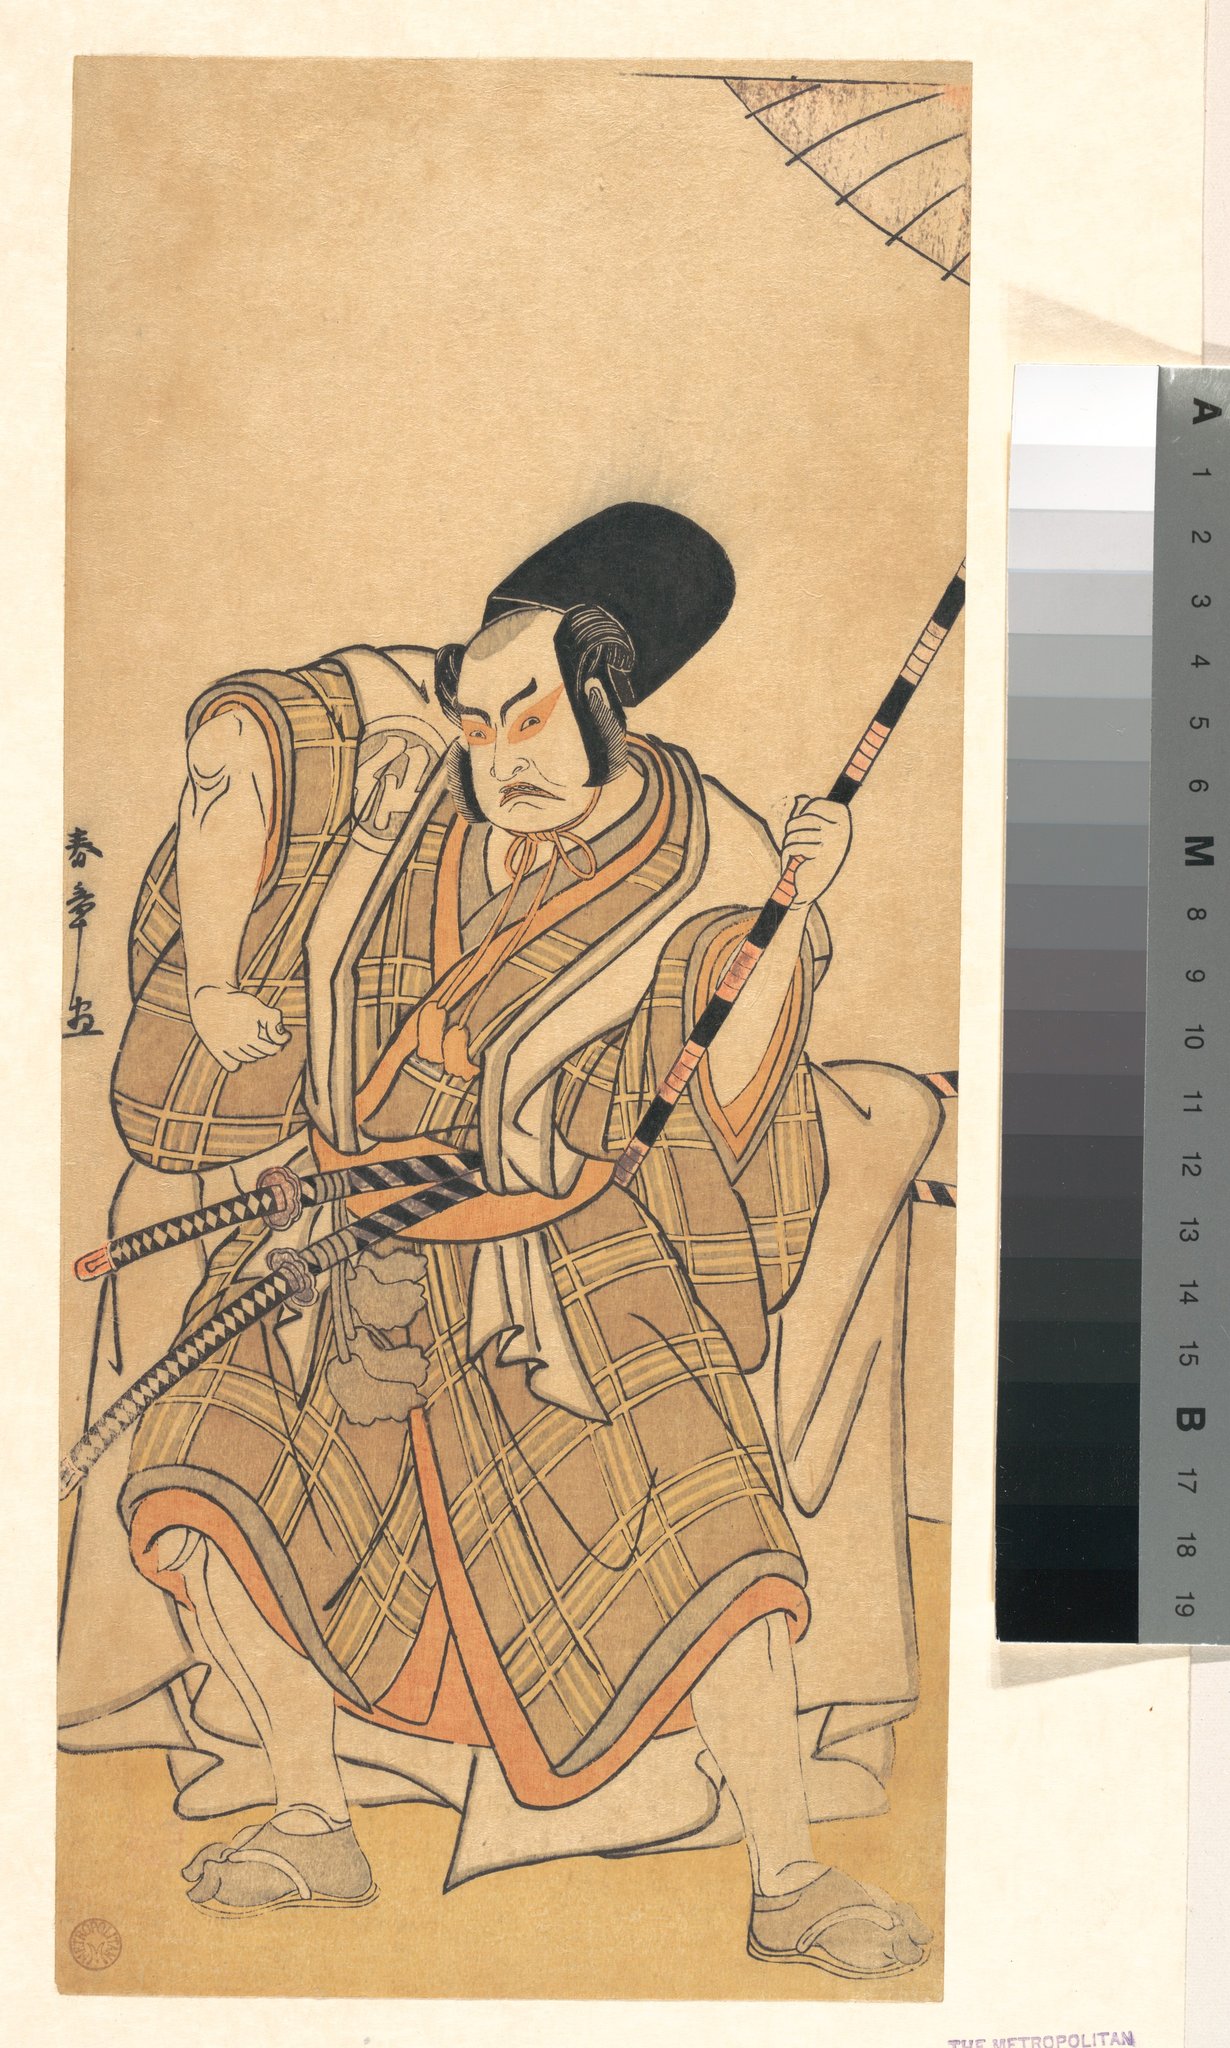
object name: woodblock print nishiki e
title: The Actor Nakamura Sukegorō II as a Samurai Disguised as a Shichō or Attendant at a Shinto Shrine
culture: japanese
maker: katsukawa shunshō 勝川春章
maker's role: artist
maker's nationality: japanese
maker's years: 1726-1792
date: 1778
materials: ink, paper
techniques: nishiki e, woodblock print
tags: swords,men,actors